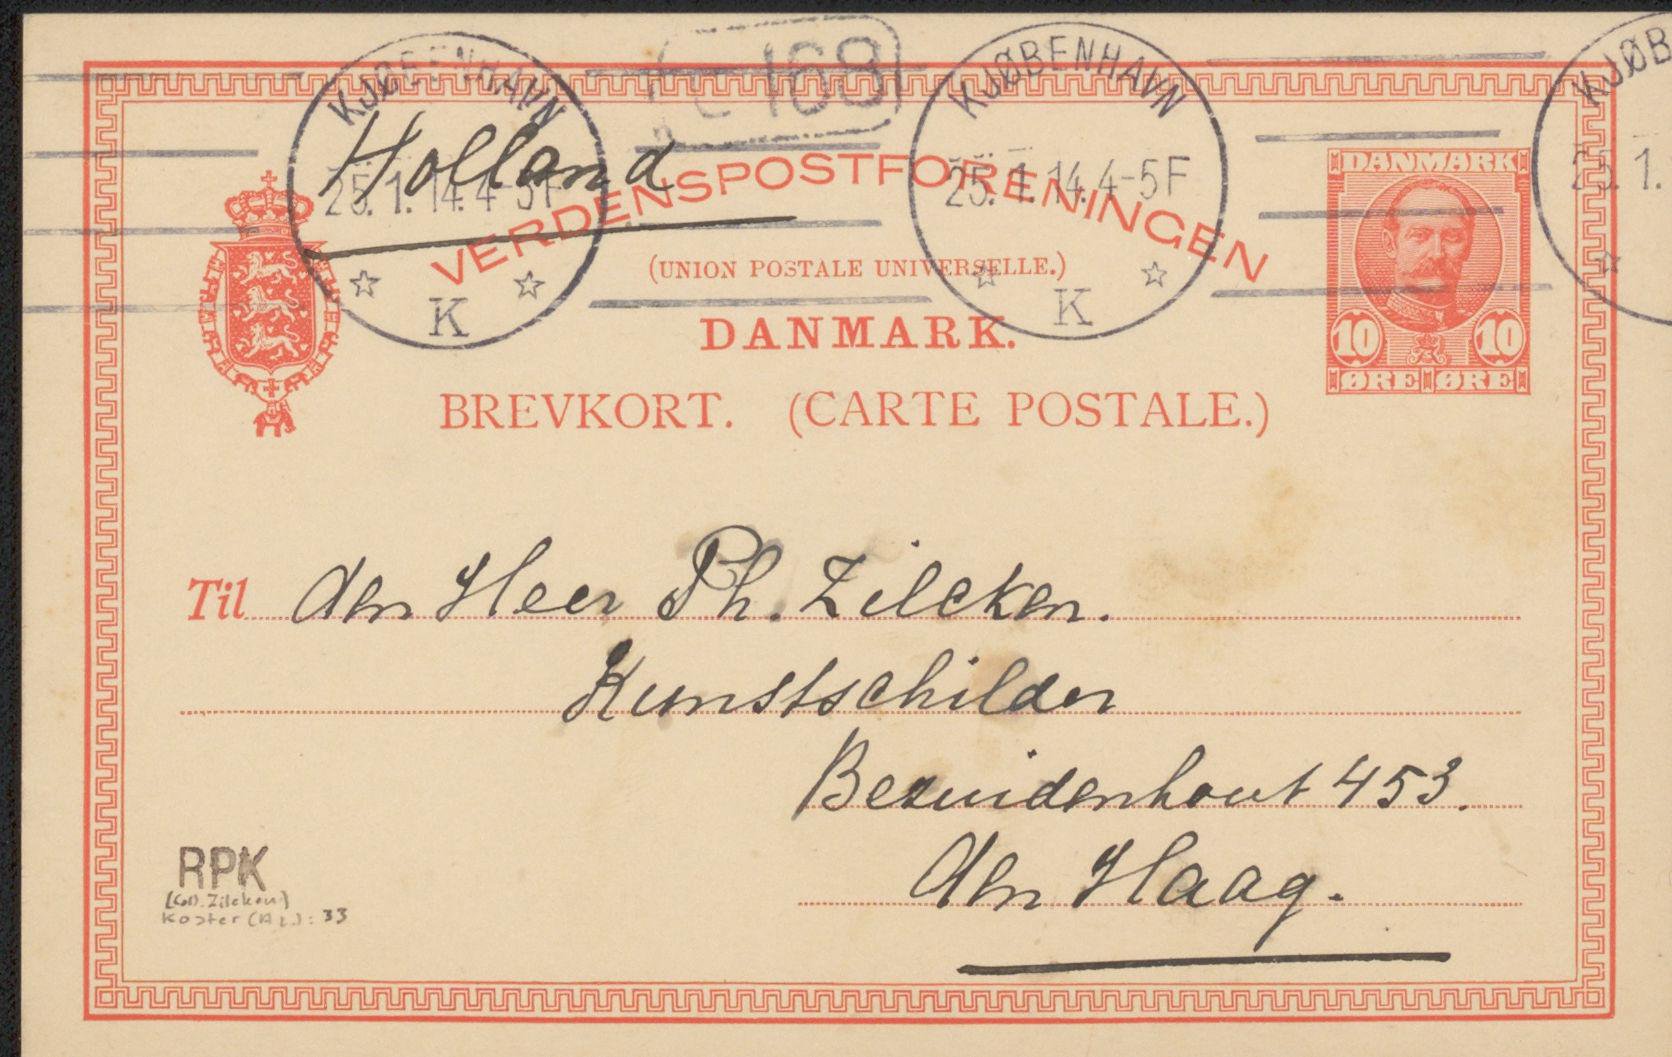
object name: postcard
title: Briefkaart aan Philip Zilcken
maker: anton l. koster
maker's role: draughtsman, painter, print maker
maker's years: 1859-1937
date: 1914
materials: cardboard, ink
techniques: pen, writing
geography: copenhagen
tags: the hague, amsterdam, marius bauer, bernard eilers, philip zilcken, the graphic arts, money, copenhagen (city), berlin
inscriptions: collector's mark: ‘RPK’